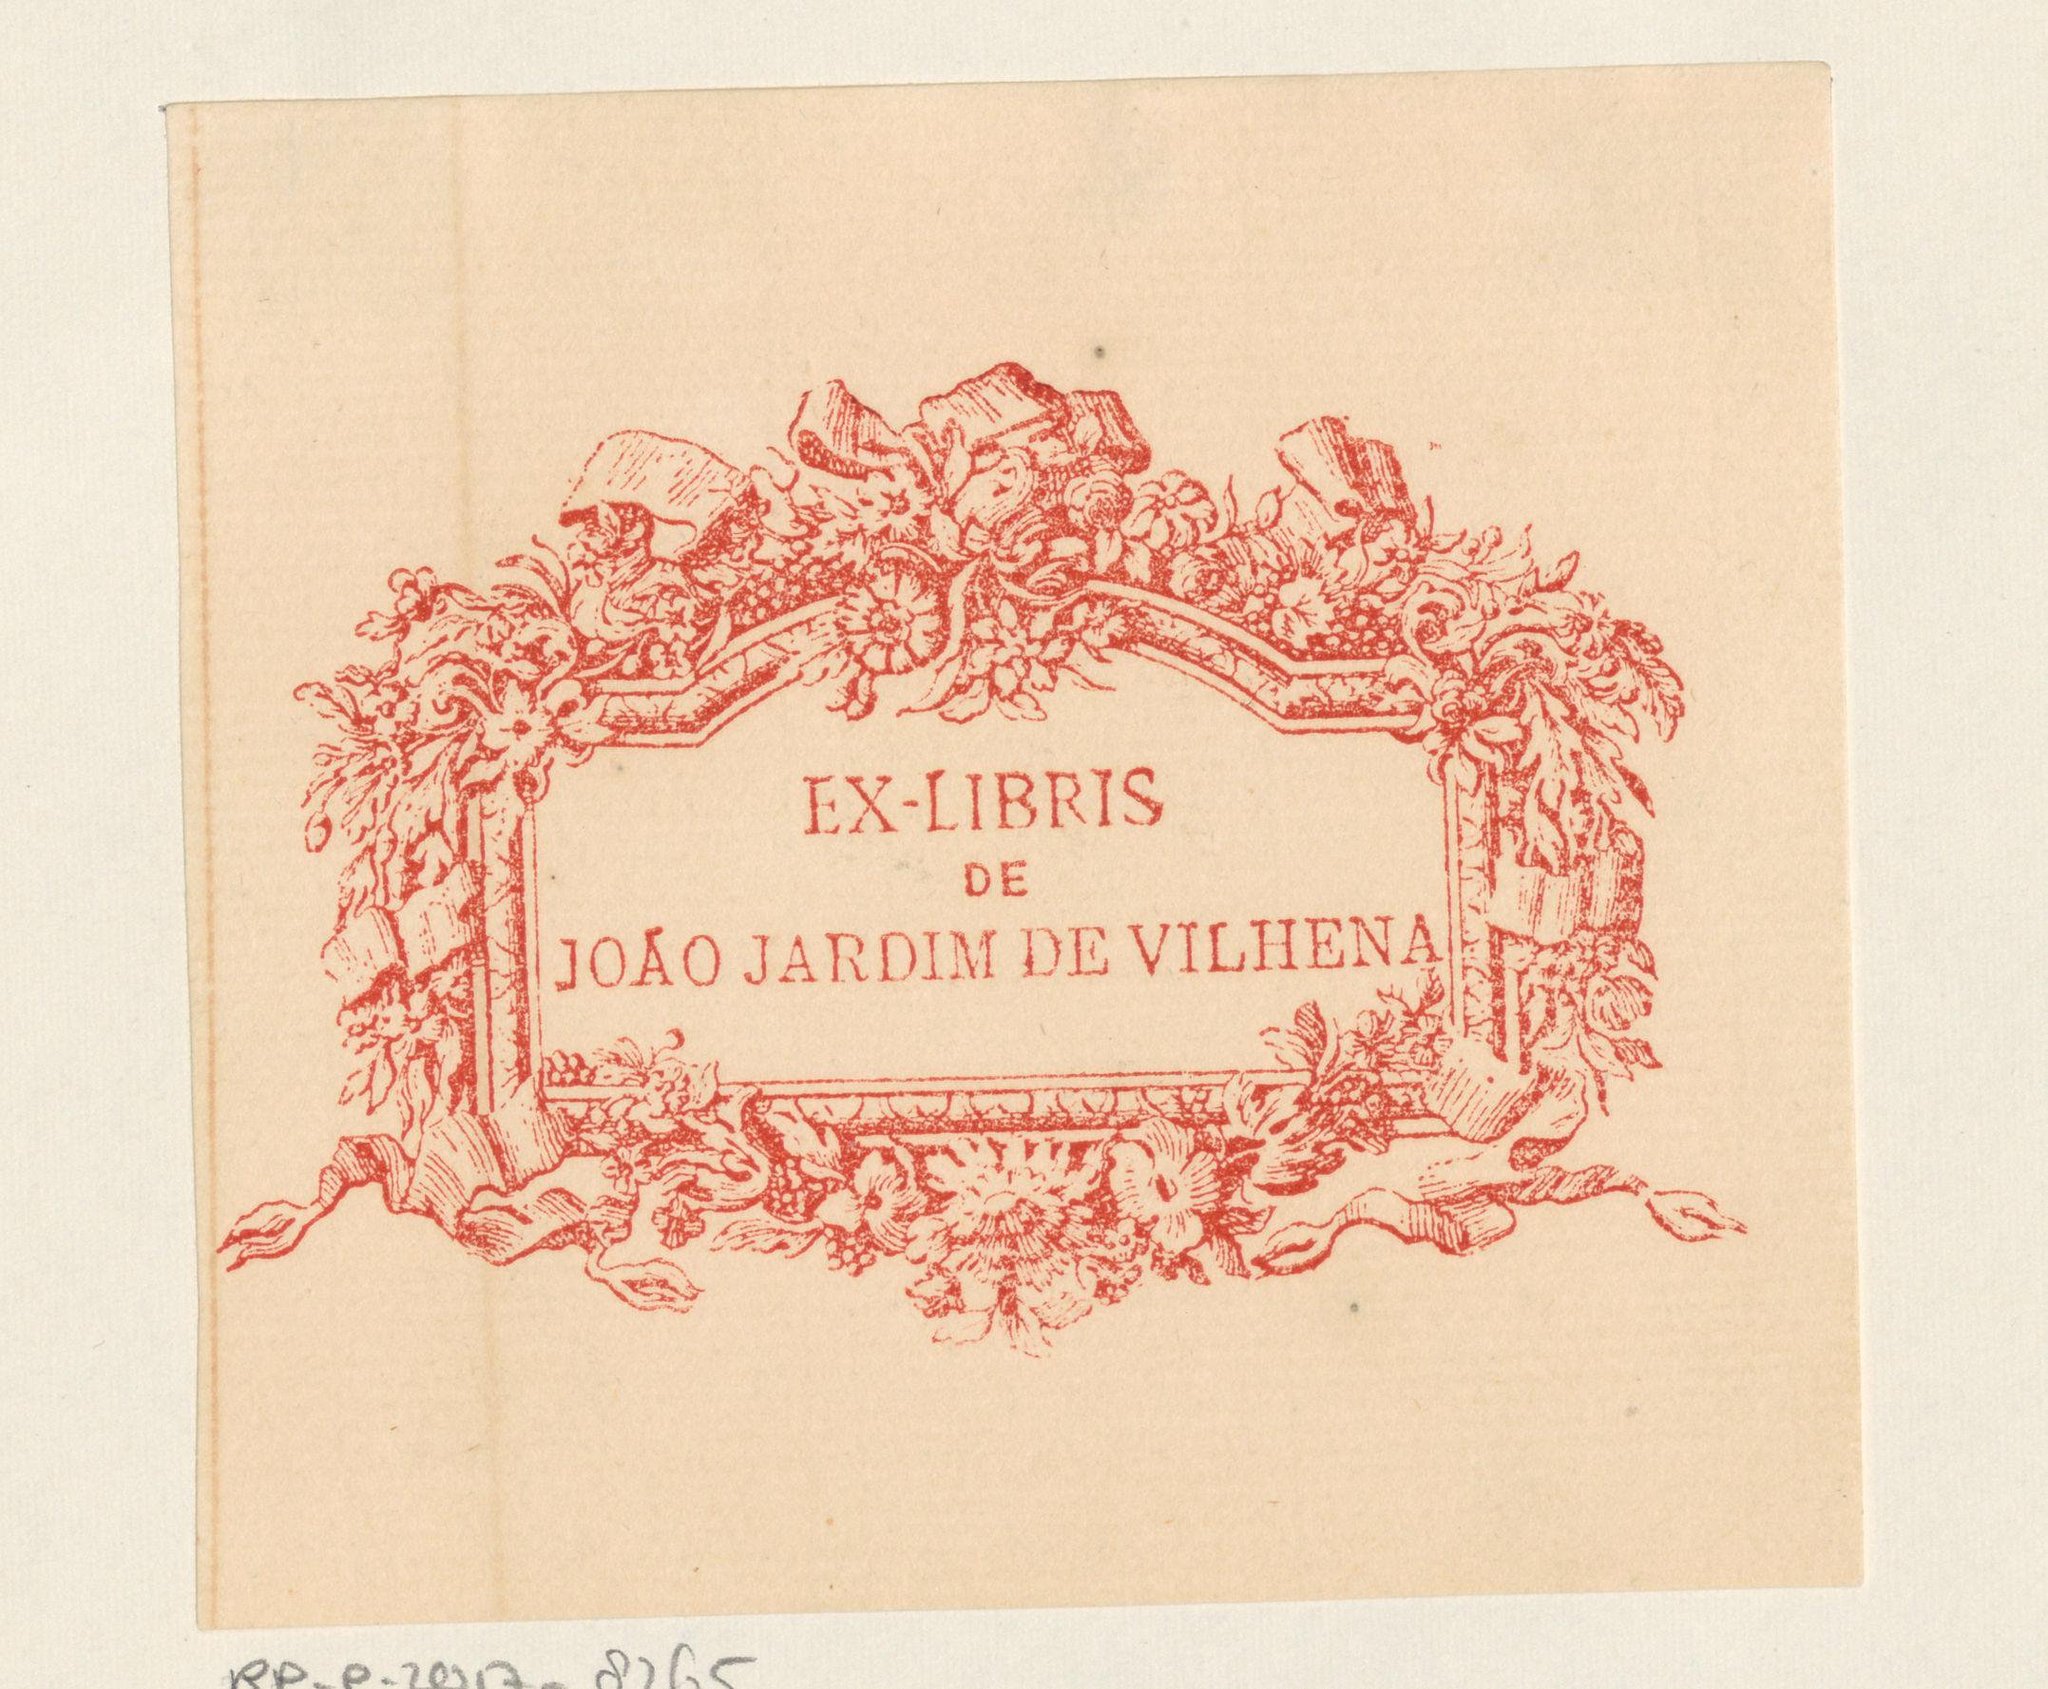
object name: bookplate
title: Ex libris van Joáo Jardim de Vilhena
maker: Anonymous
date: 1883-1966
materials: paper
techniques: printing block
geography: portugal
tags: politician, cut flowers; nosegay, bunch of flowers